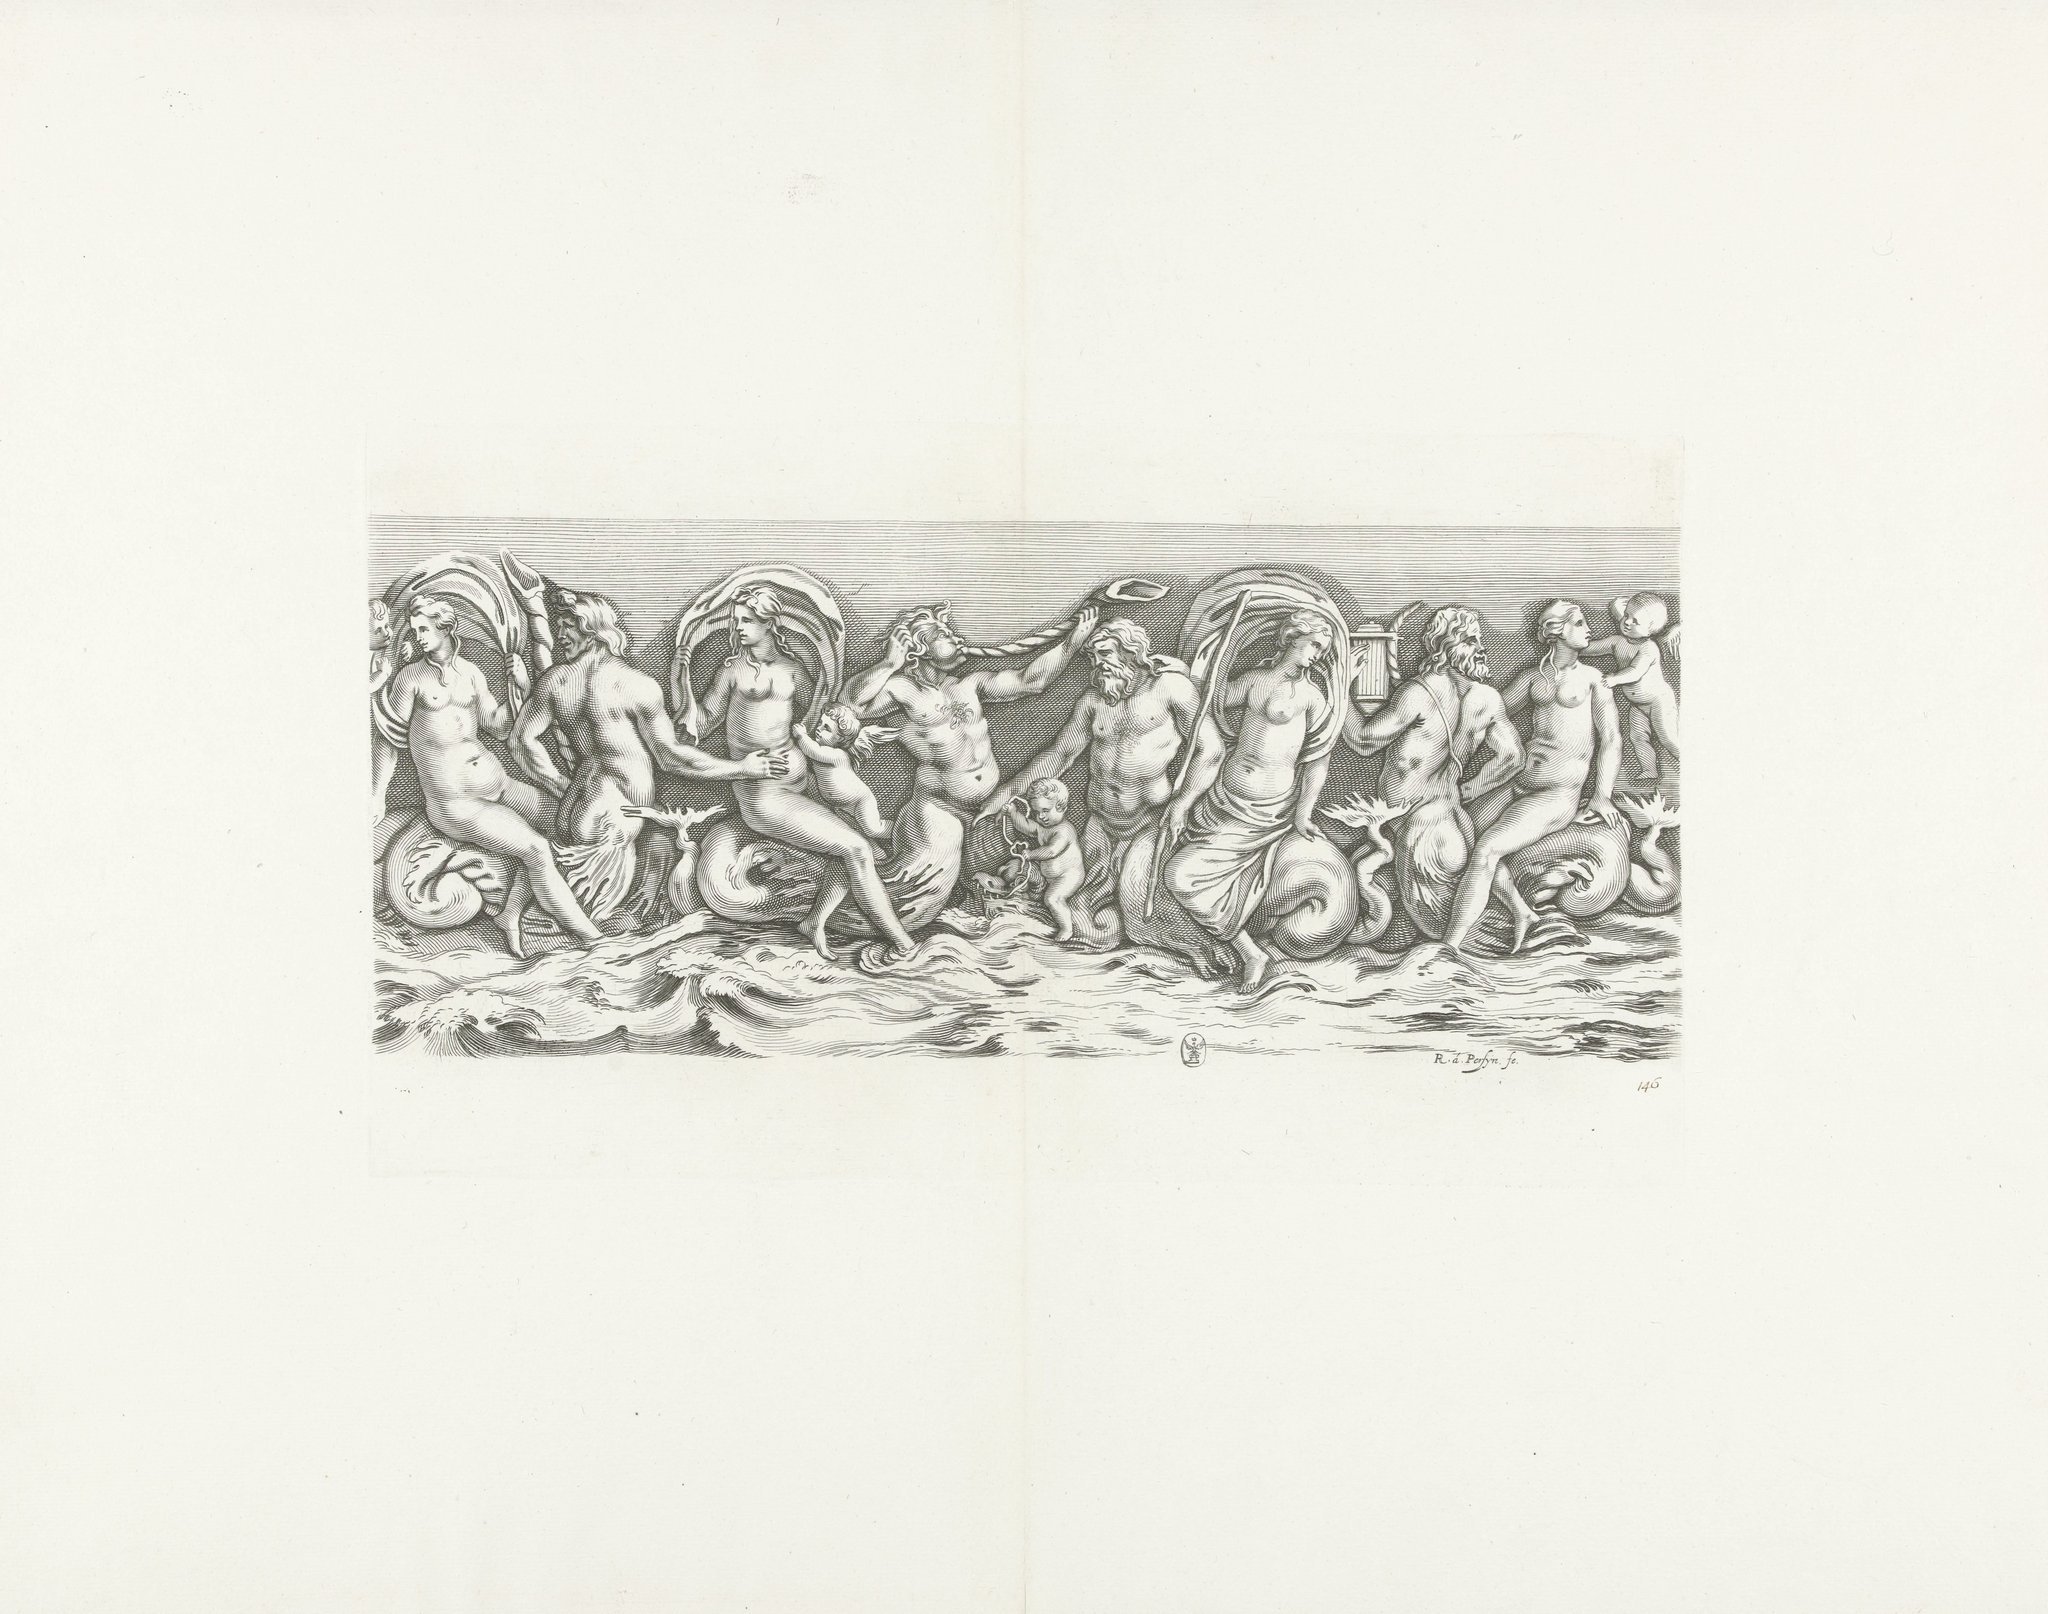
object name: print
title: Galleria Giustiniana del Marchese Vincenzo Giustiniani II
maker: reinier van persijn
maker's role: draughtsman, painter, print maker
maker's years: 1614-1668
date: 1640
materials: paper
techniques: engraving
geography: rome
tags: vincenzo giustiniani (1564-1637), triton(s), nymphs (in general); 'ninfe in commune' (ripa), piece of sculpture, reproduction of a piece of sculpture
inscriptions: collector's mark: Lugt 2228, number: ‘146’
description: Romeins bas-reliëf van een sarcofaag met nimfen die door tritons over het water gevoerd worden. Midden onder het wapenschild van Vincenzo Giustiniani. Prent uit een publicatie met reproductieprenten naar de sculpturen in de verzameling in de Galleria Giustiniani te Rome.